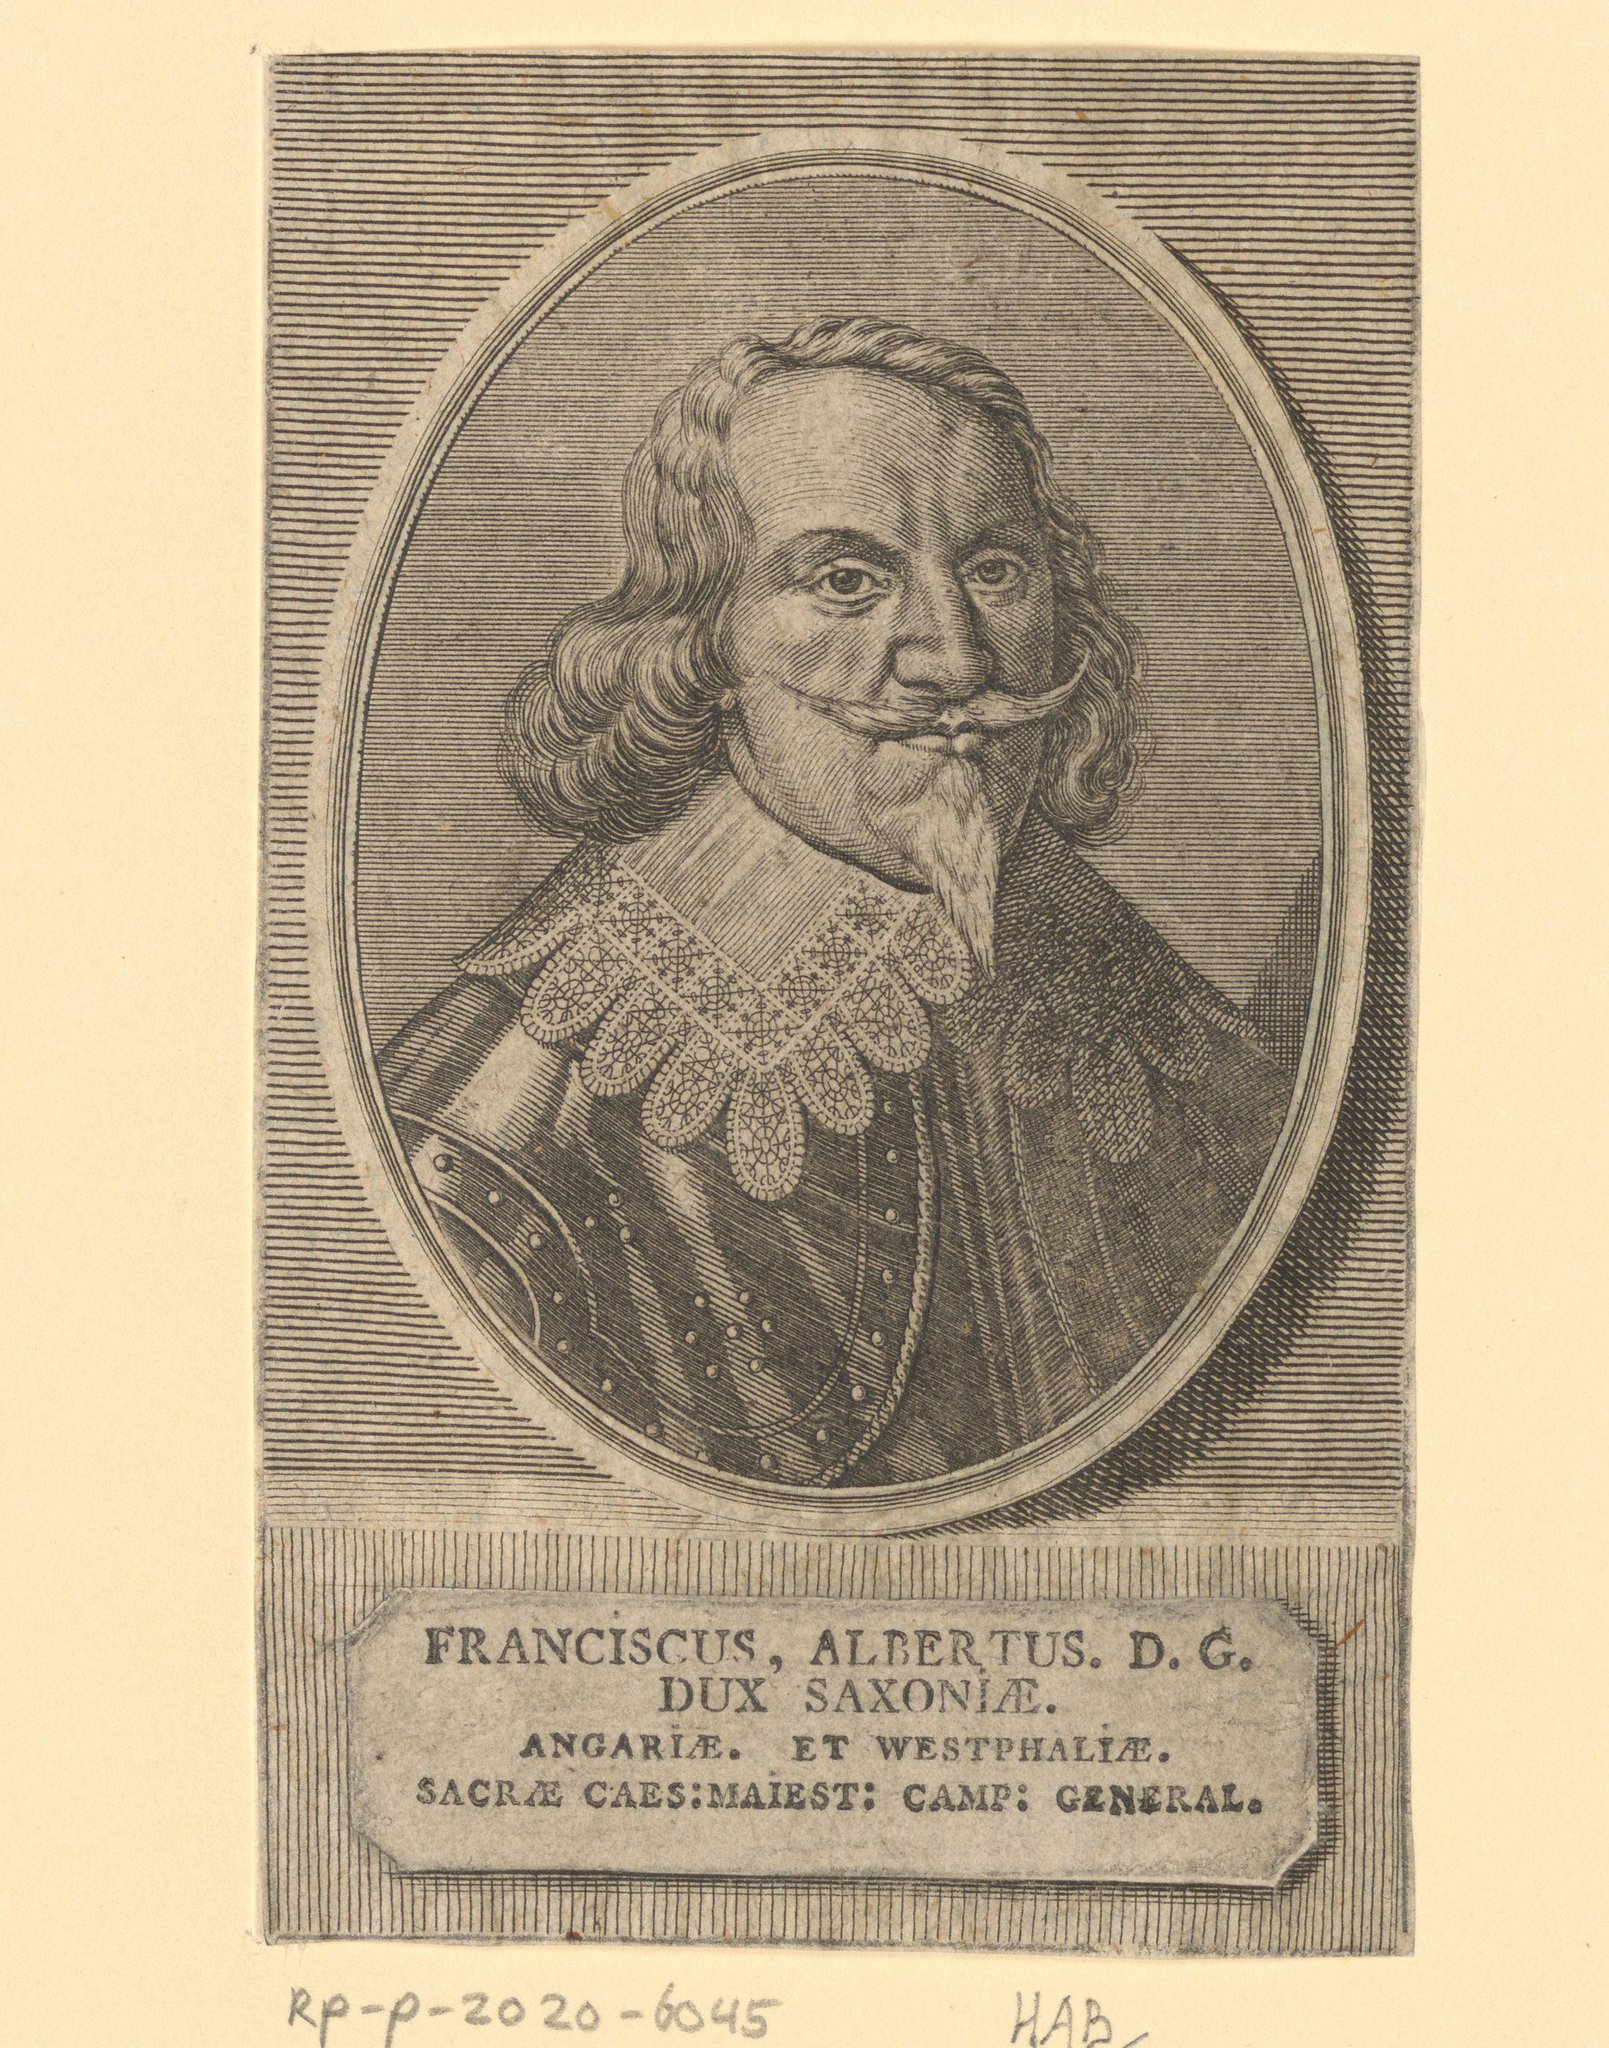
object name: book illustration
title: Portret van Frans Albert hertog van Saksen-Lauenburg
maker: Anonymous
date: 1692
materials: paper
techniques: engraving, etching, letterpress printing, snipping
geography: germany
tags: armour, historical persons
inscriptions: inscription: ‘13 Mei 1642’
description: Portret geknipt uit: Oraeus, Heinrich. Theatrum Europaeum (...). 4e druk. Frankfurt am Main: erven Matthäus Merian, 1692, dl. 4. Niet bekend waar het onderschrift en de omlijsting uit komen.